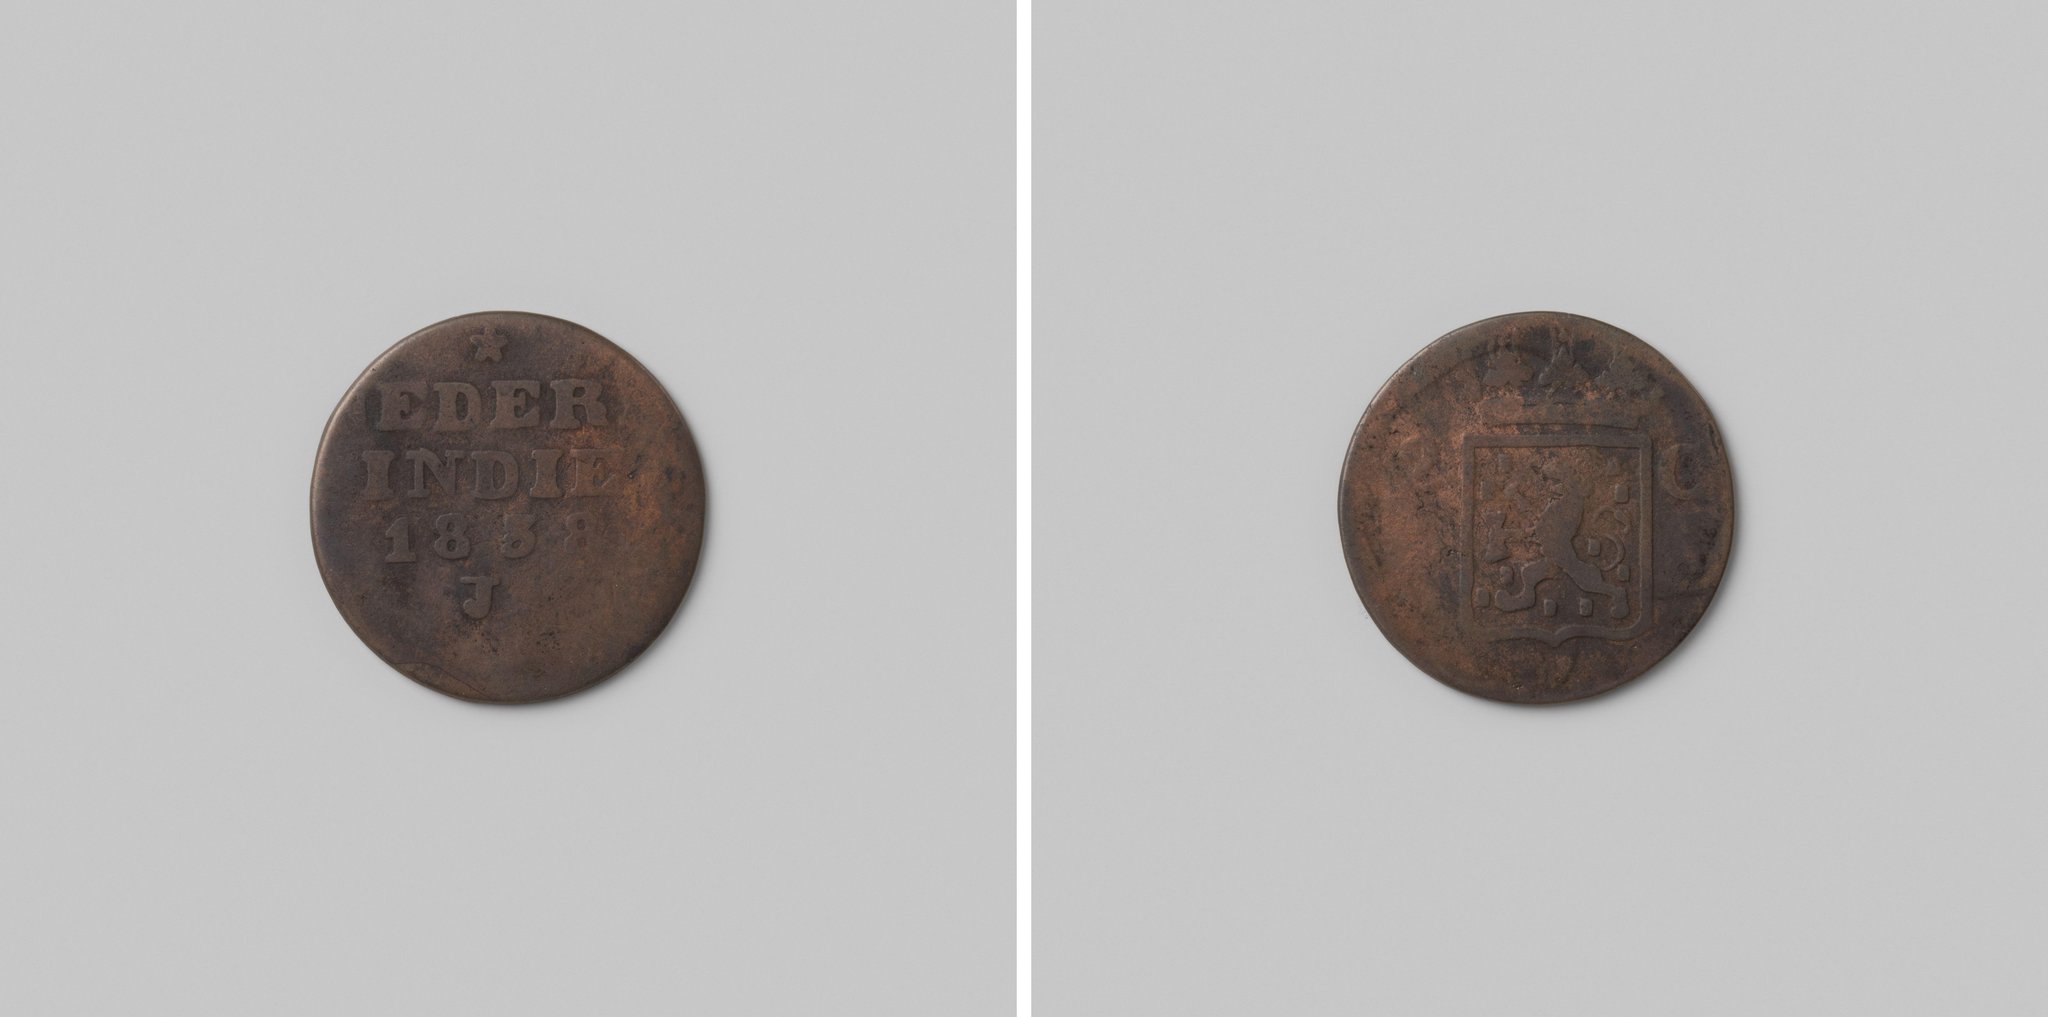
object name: coin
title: Koperen VOC-munt uit 1838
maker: Anonymous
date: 1838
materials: copper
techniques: striking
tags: dutch east indies, the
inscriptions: inscription: ‘* NEDERL / INDIE / 1838 / J’, inscription: ‘C’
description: Koperen VOC-muntje uit 1838 uit Nederlands-Indië. Voorzijde: opschrift. Keerzijde: wapen met leeuw erin. Het muntje zit in een vierkant envelopje met opschrift.